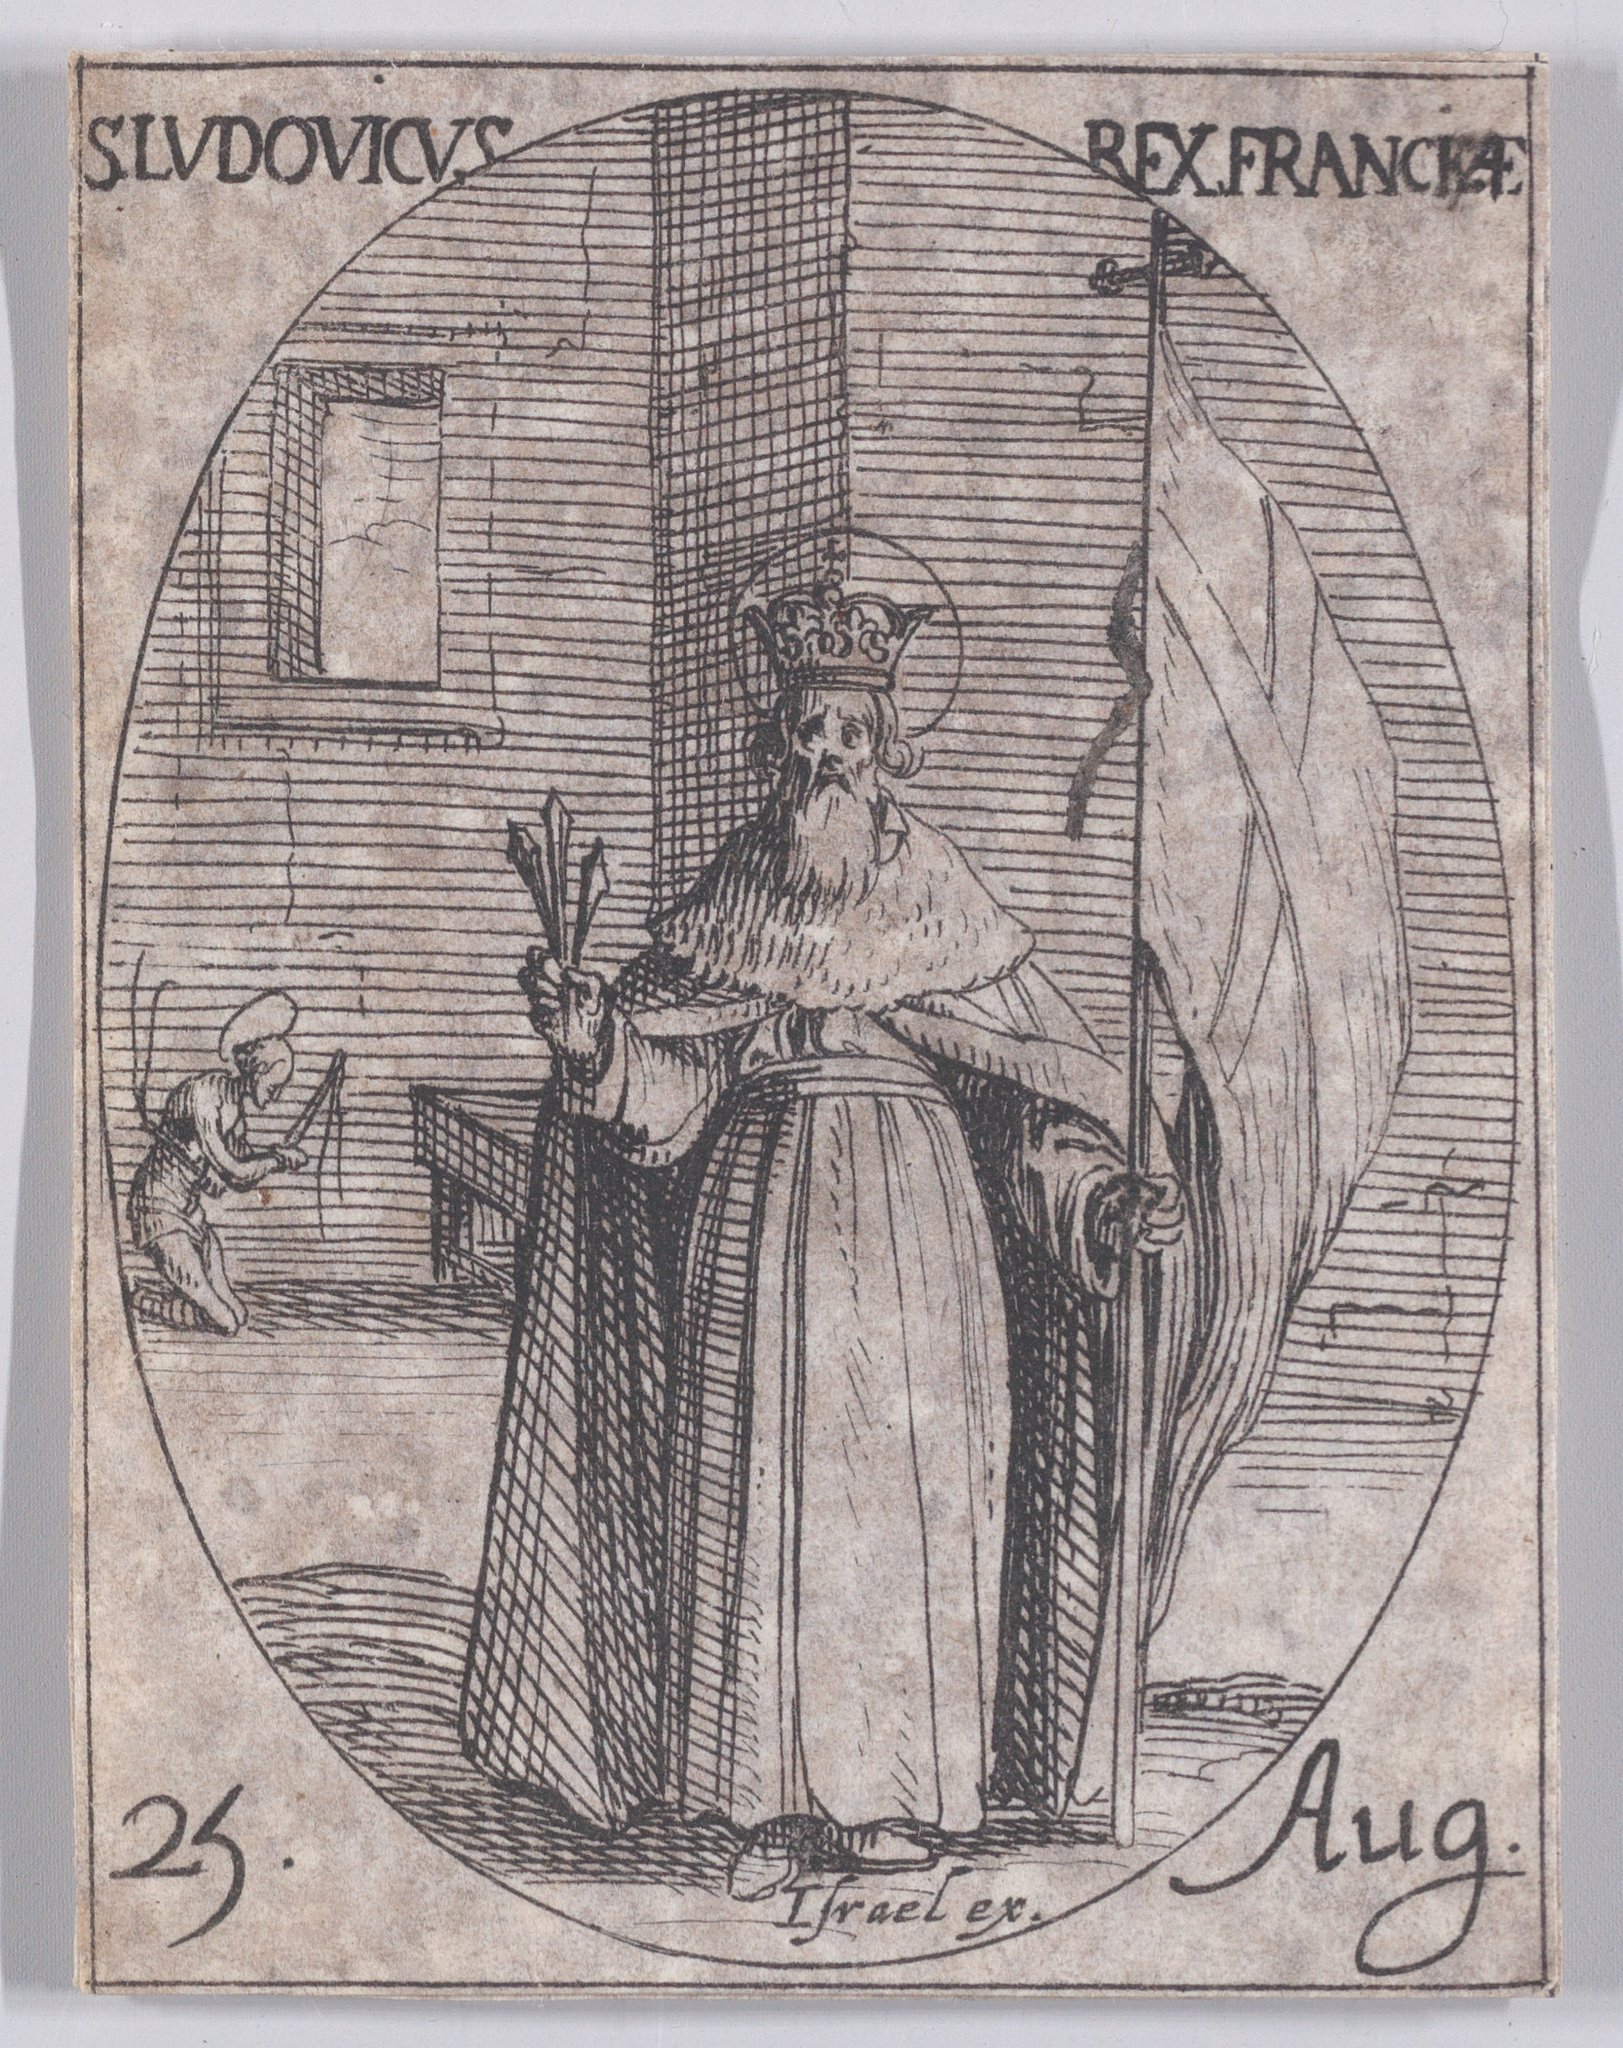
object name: print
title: S. Louis, Roi de France (St. Louis, King of France), August 25th, from "Les Images De Tous Les Saincts et Saintes de L'Année" (Images of All of the Saints and Religious Events of the Year)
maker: jacques callot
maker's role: artist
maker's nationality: french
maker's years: 1592-1635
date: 1636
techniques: etching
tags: kings,men,saints